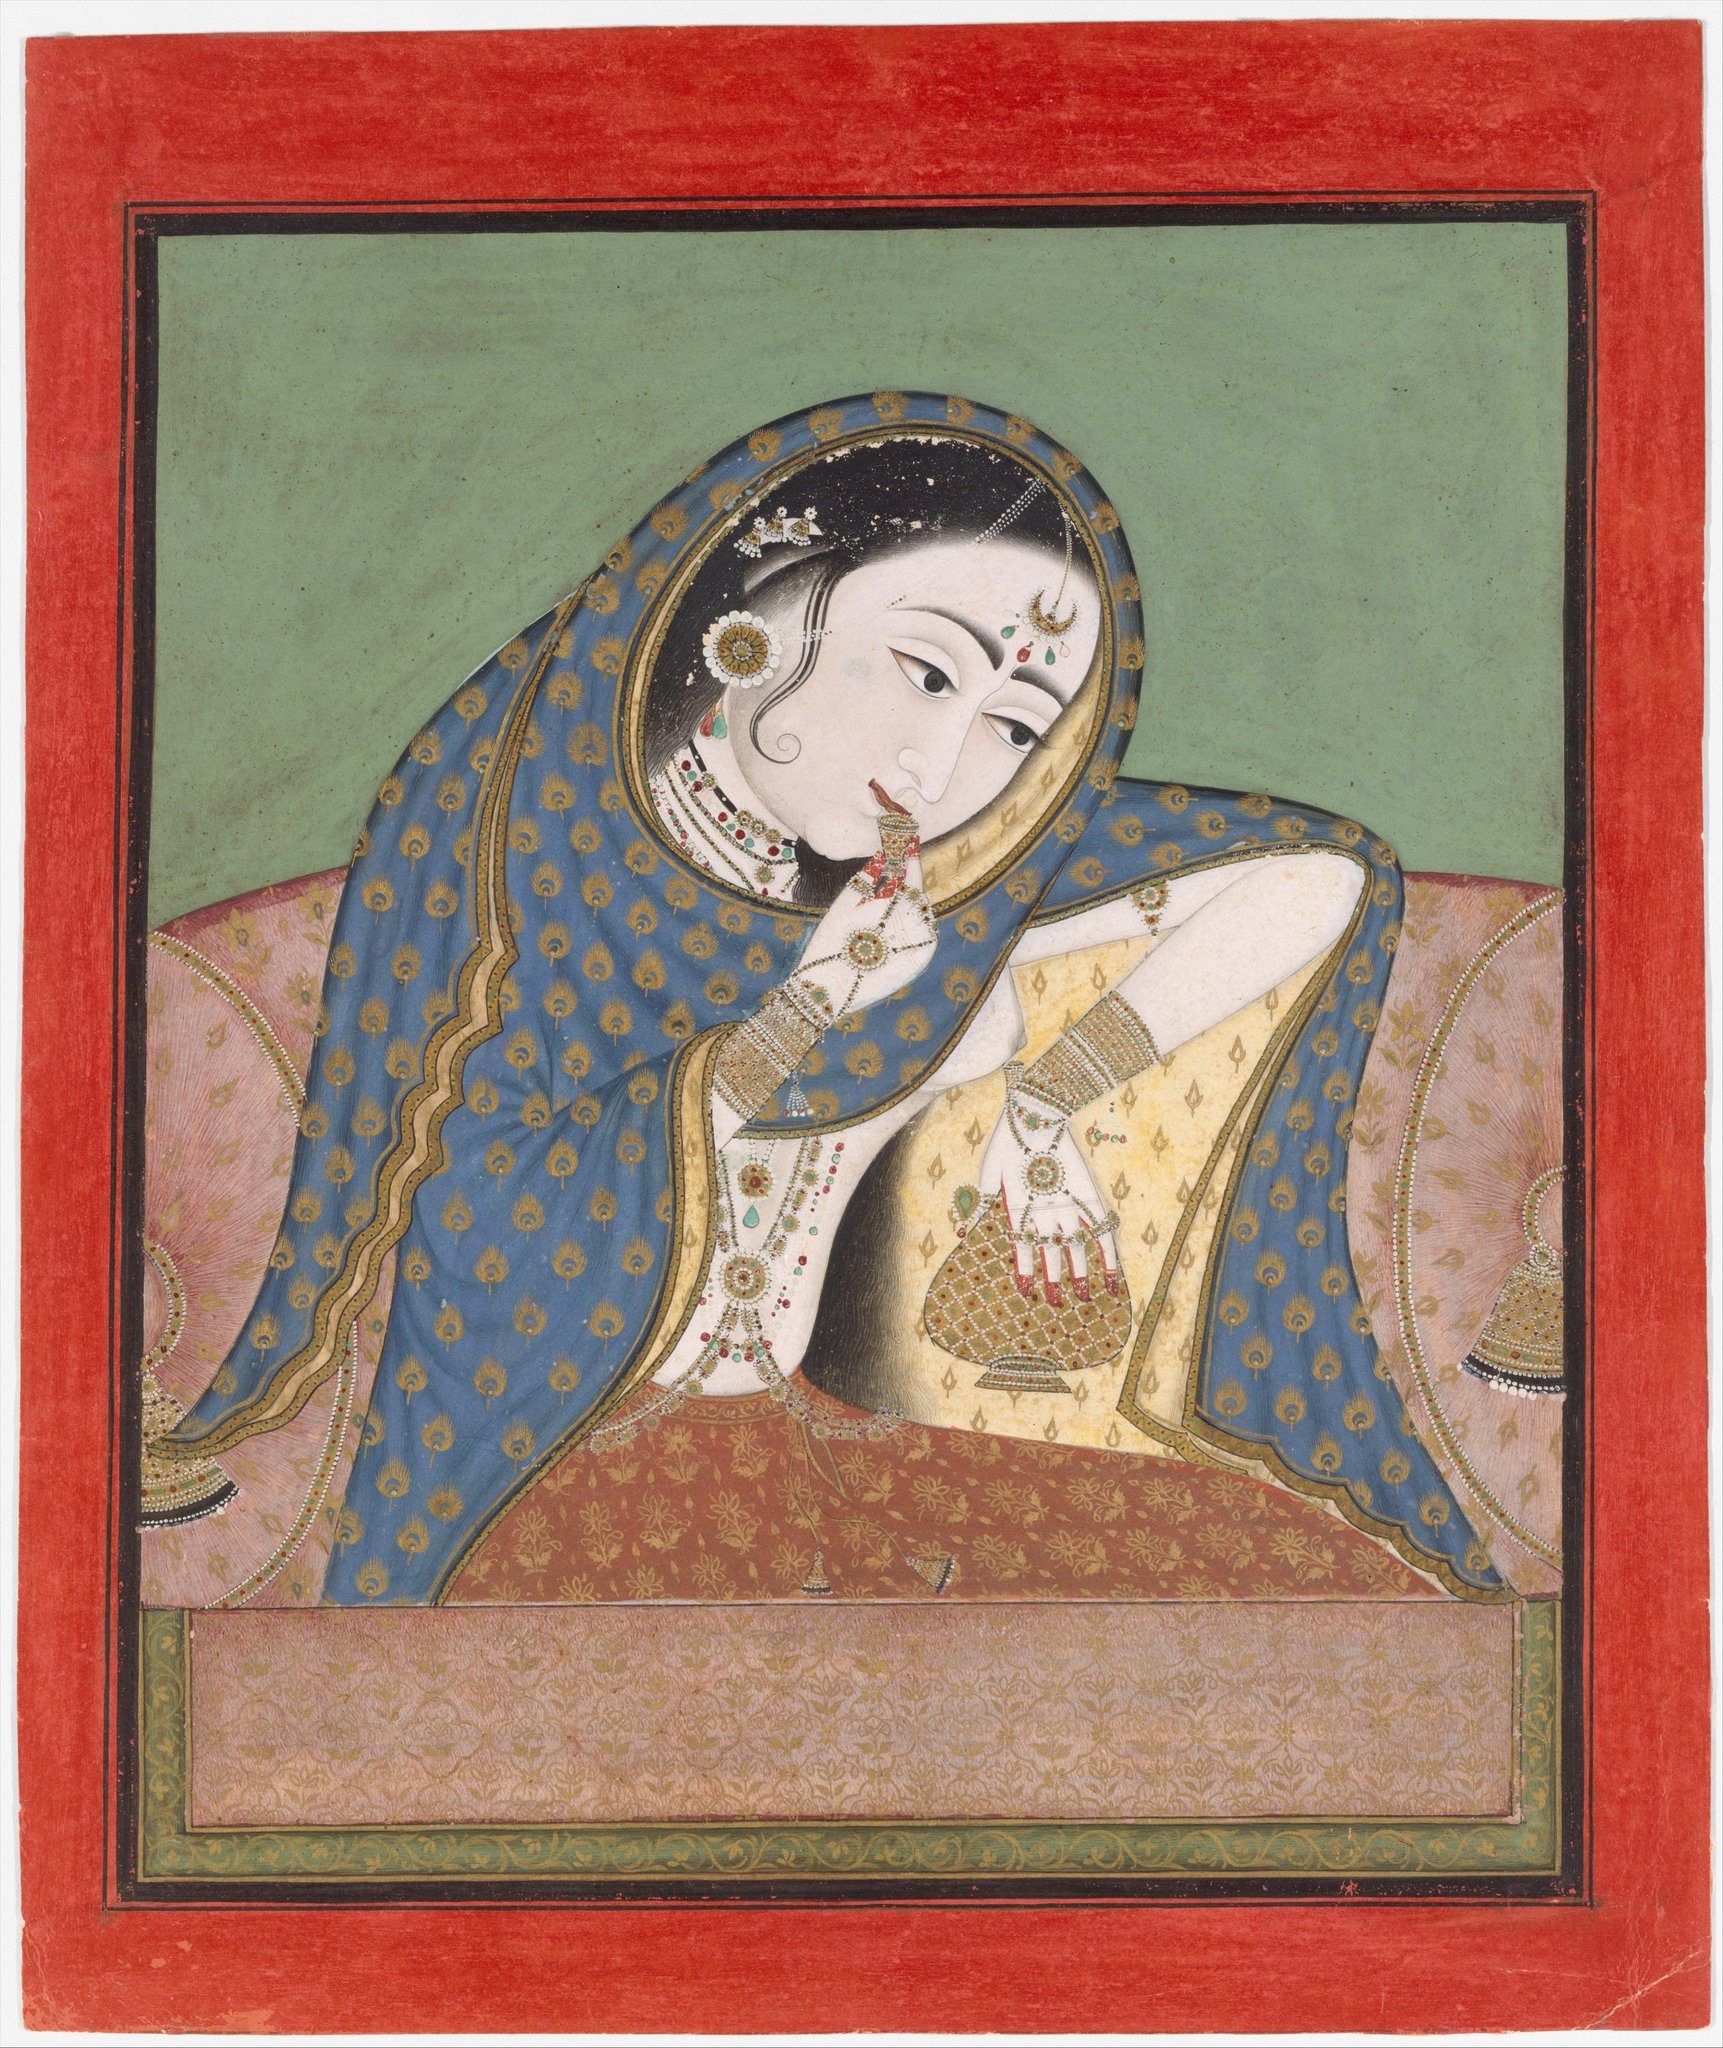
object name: painting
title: Melancholy Courtesan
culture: indian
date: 1750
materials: gold, ink, paper, watercolor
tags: women